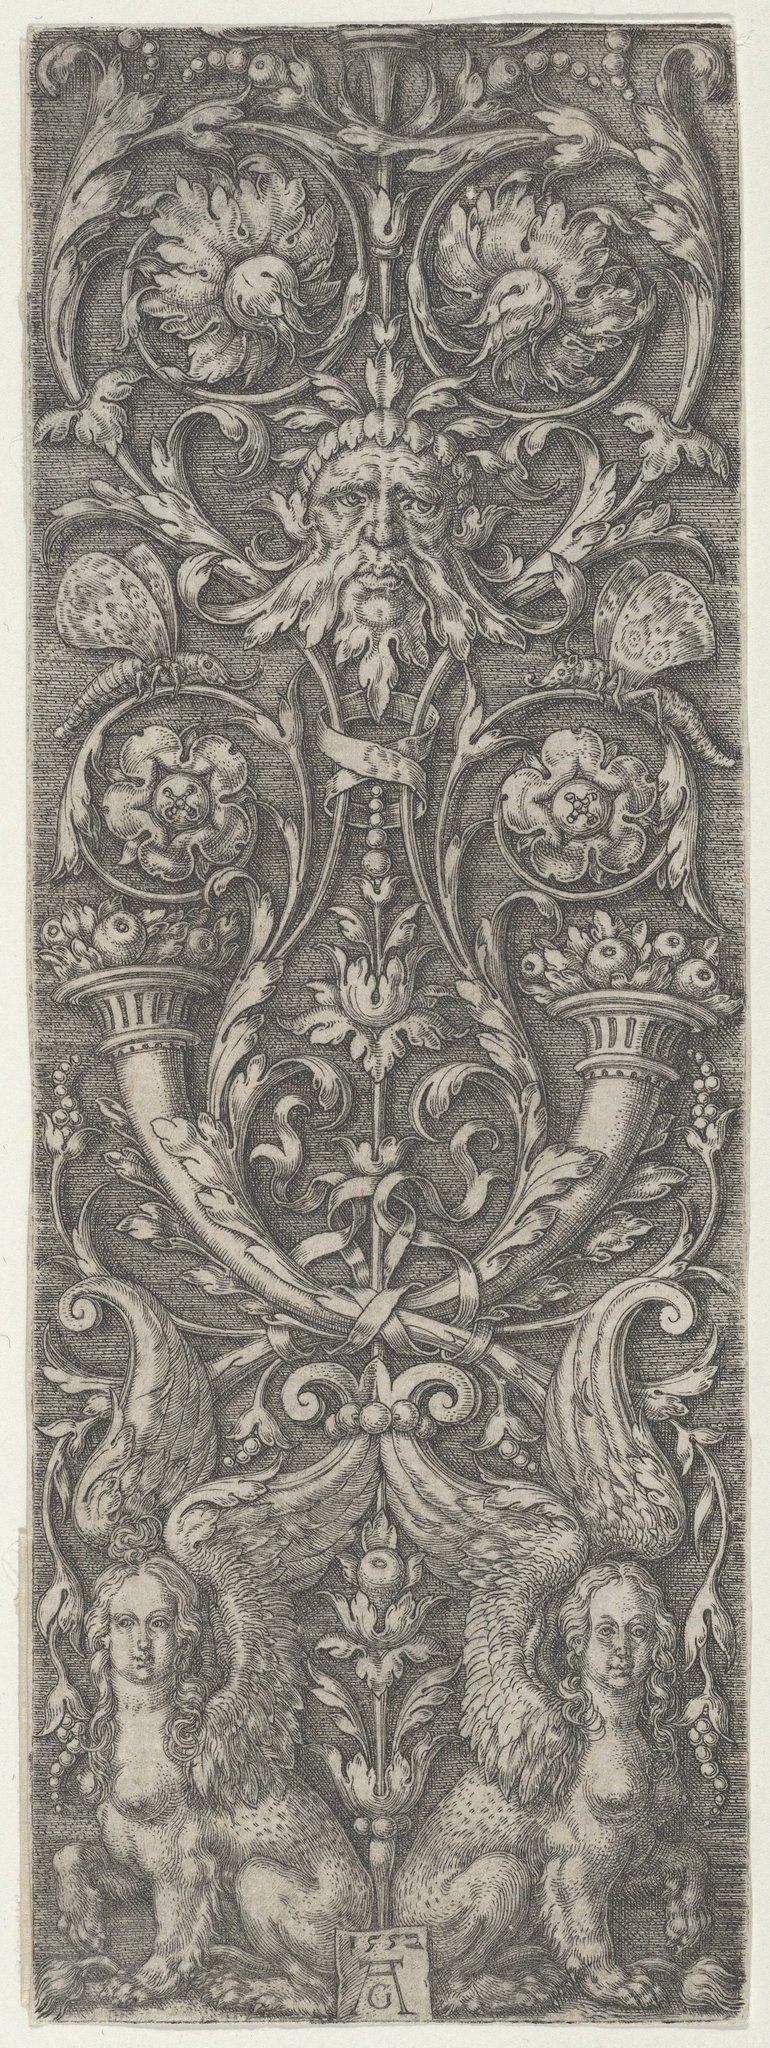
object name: print ornament architecture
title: Vertical Panel with Candelabrum Grotesques Containing Cornucopias and Sphinxes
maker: heinrich aldegrever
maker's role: artist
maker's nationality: german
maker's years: 1502-1561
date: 1552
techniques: engraving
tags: grotesques,ornament,sphinx,cornucopia